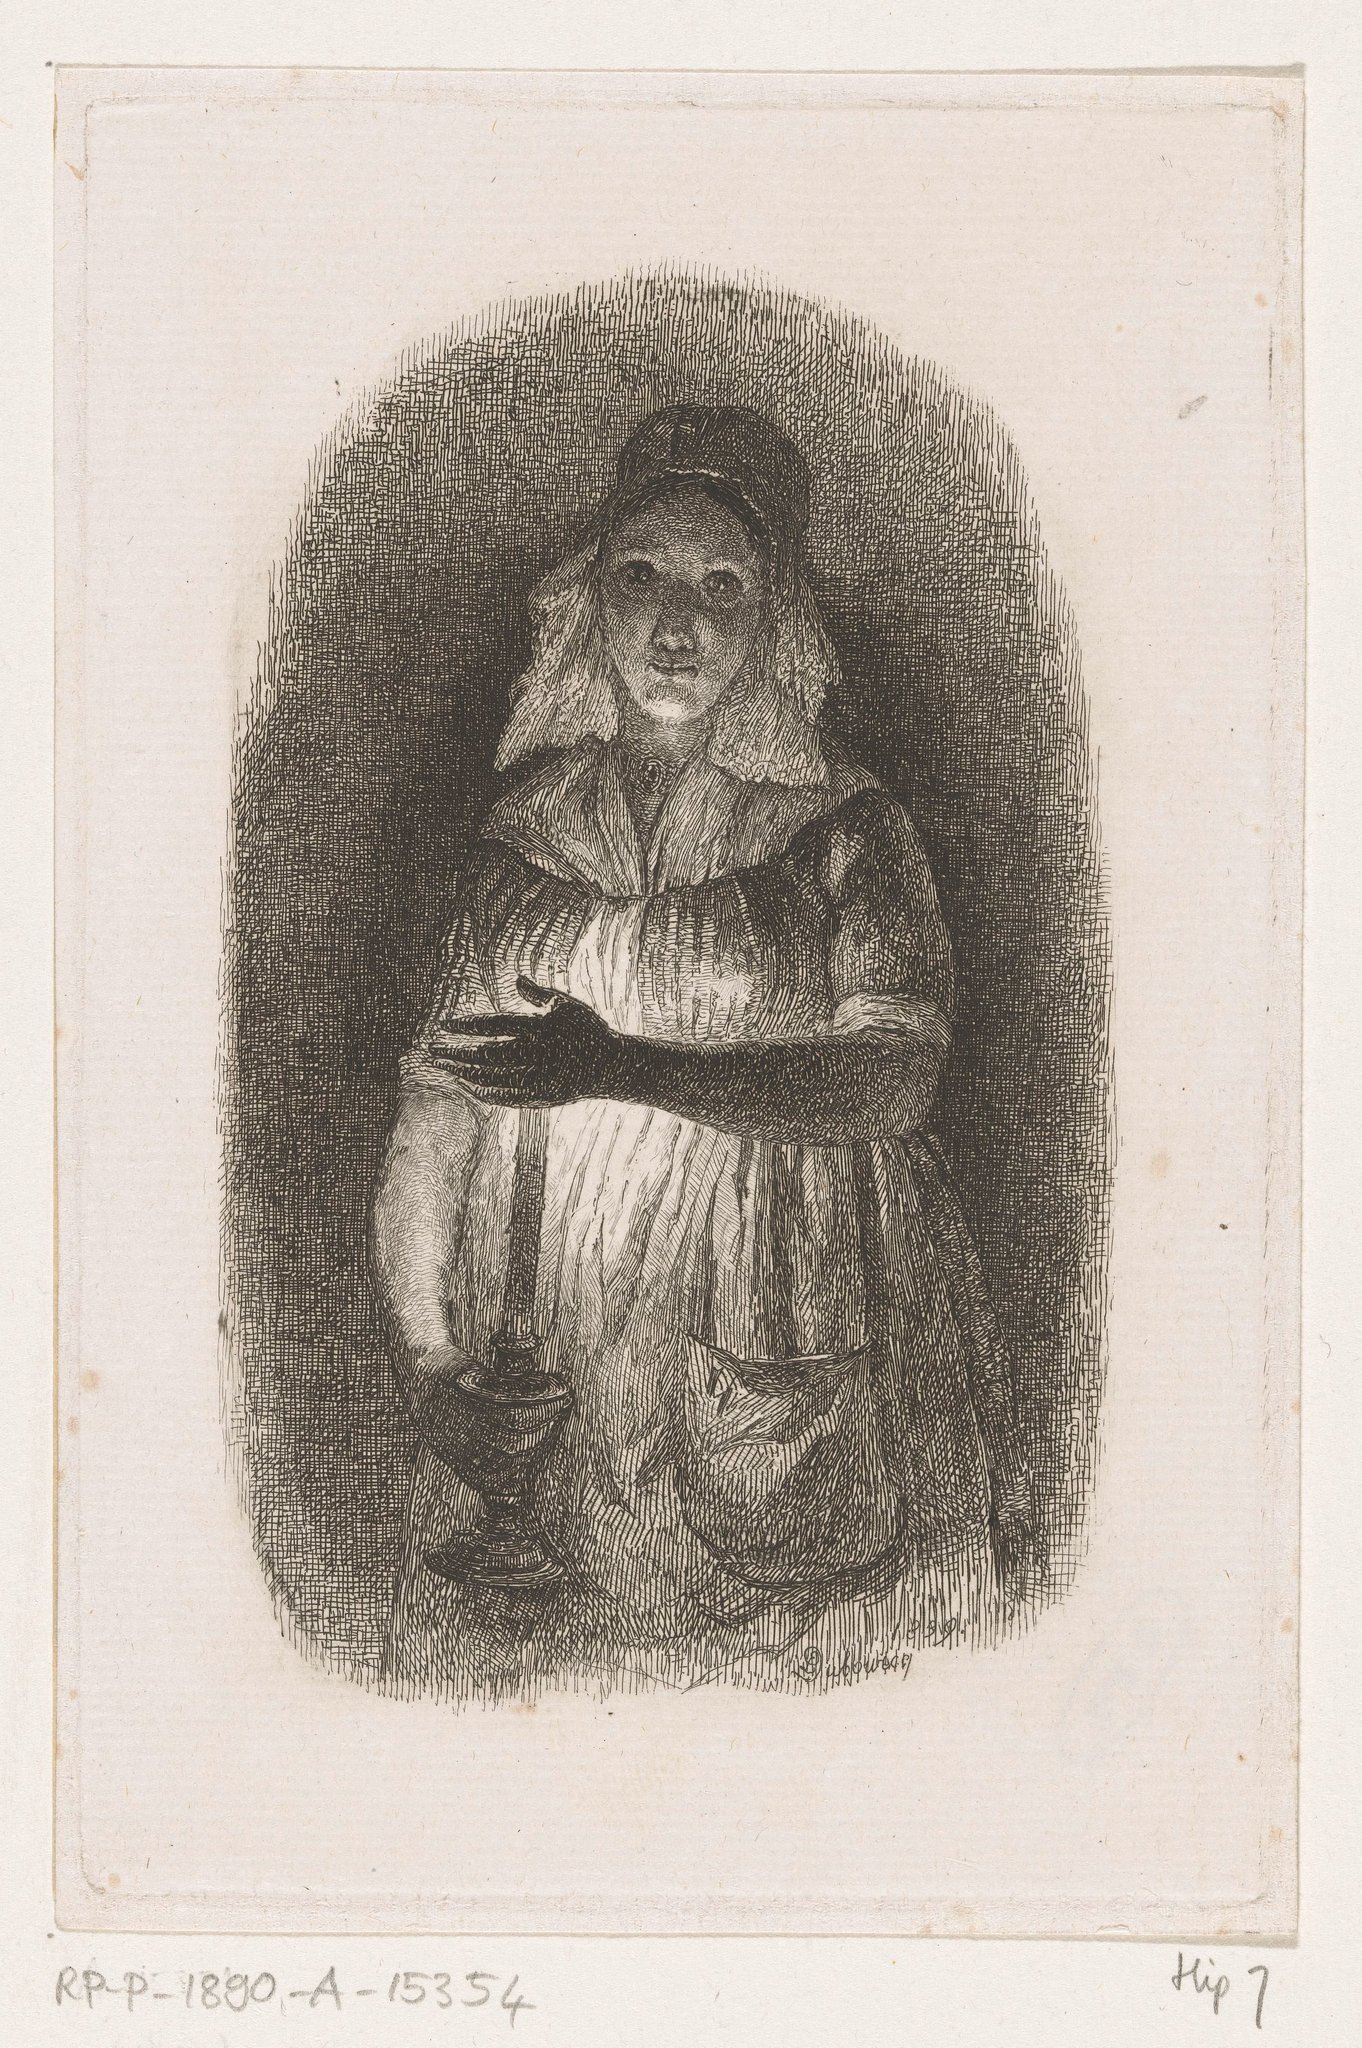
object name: print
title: Dienstmeisje met brandende kaars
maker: pierre louis dubourcq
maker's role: draughtsman, painter, print maker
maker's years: 1815-1873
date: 1839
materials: paper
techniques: etching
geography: netherlands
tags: maid ~ house personnel, chandelier, candelabrum (+ kindling a light; lit, burning light, lamp, candle)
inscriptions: collector's mark: Lugt 2228